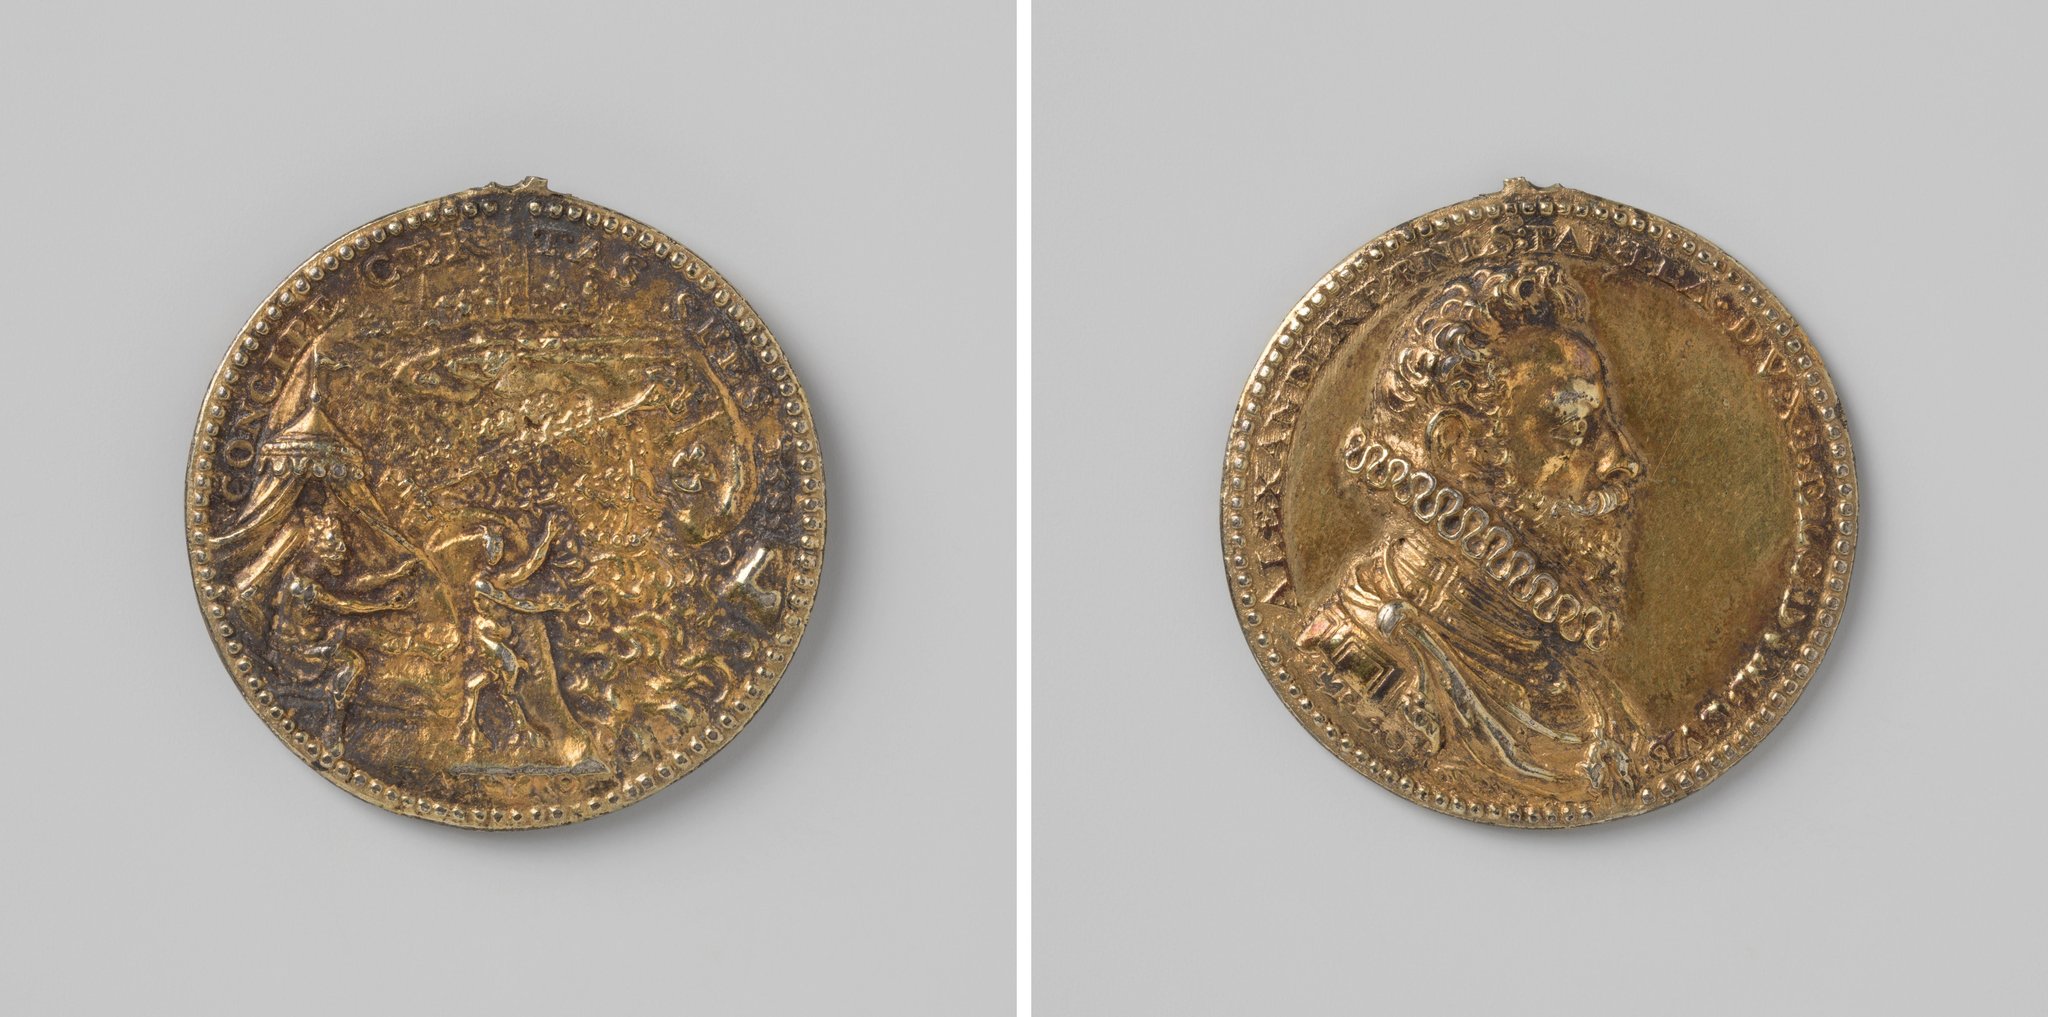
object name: history medal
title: Beleg en inname van Antwerpen door de hertog van Parma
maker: jacques jonghelinck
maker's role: medailleur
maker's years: 1530-1606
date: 1585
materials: silver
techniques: gilding, striking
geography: antwerp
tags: vienna, albert casimir van saksen-teschen, rome, alessandro farnese (landvoogd van de nederlanden en hertog van parma en piacenza), antwerp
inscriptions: circumscription: ‘CONCIPE CERTAS SPES 1585 / ΣATROΣ’, circumscription: ‘ALEXANDER FARNES PAR PLA DVX BELG DVM GVB / AET 40.’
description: Zilveren penning met afgebroken draagoog. Voorzijde: borststuk man binnen omschrift. Keerzijde: Satyr toont van zijn bed opstaande hertog van Parma het onder water gezette land, de schipbrug en de stad Antwerpen binnen omschrift.